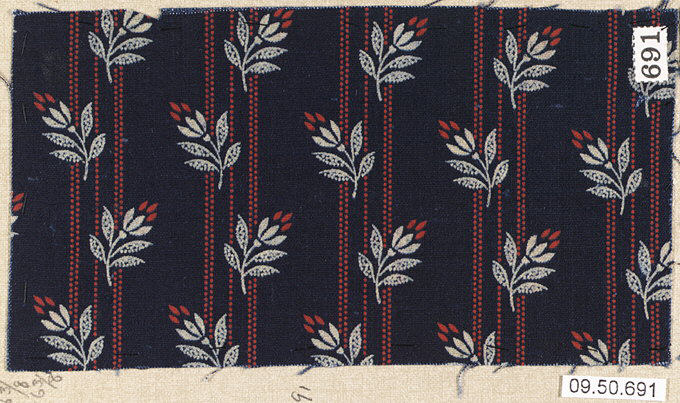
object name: piece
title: Pieces (4)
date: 1801-1900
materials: cotton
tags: leaves